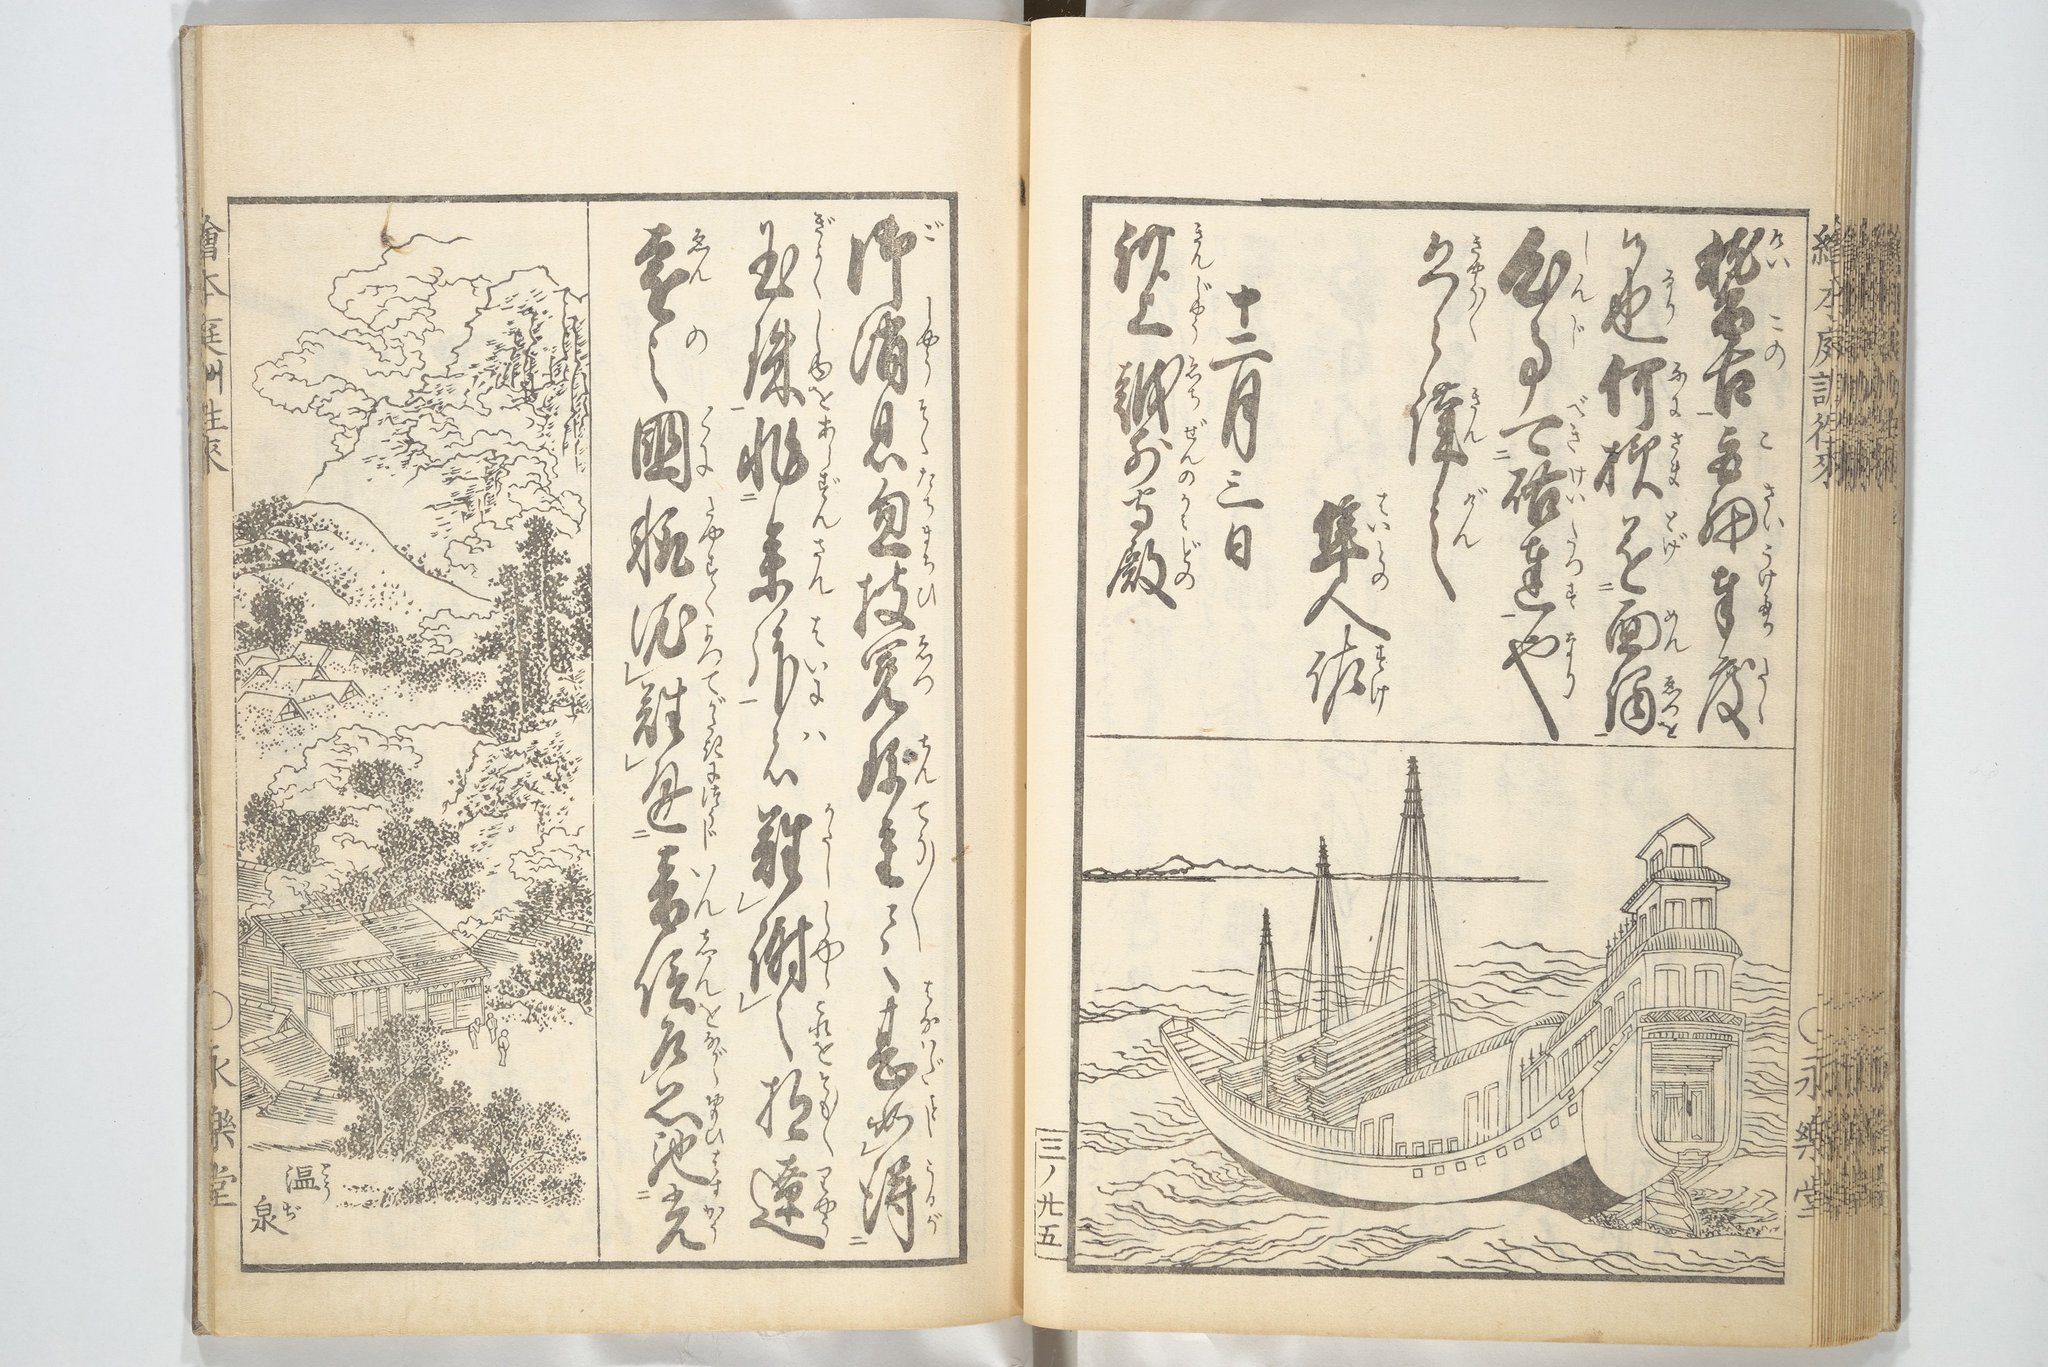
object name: illustrated book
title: Picture Book on the Communication of Home Precepts part III (Ehon teikin ōrai gehen) 絵本庭訓往来下編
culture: japanese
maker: katsushika hokusai 葛飾北斎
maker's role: artist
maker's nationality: japanese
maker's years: 1760-1849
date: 1848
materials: ink, paper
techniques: woodblock print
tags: men,landscapes,ships